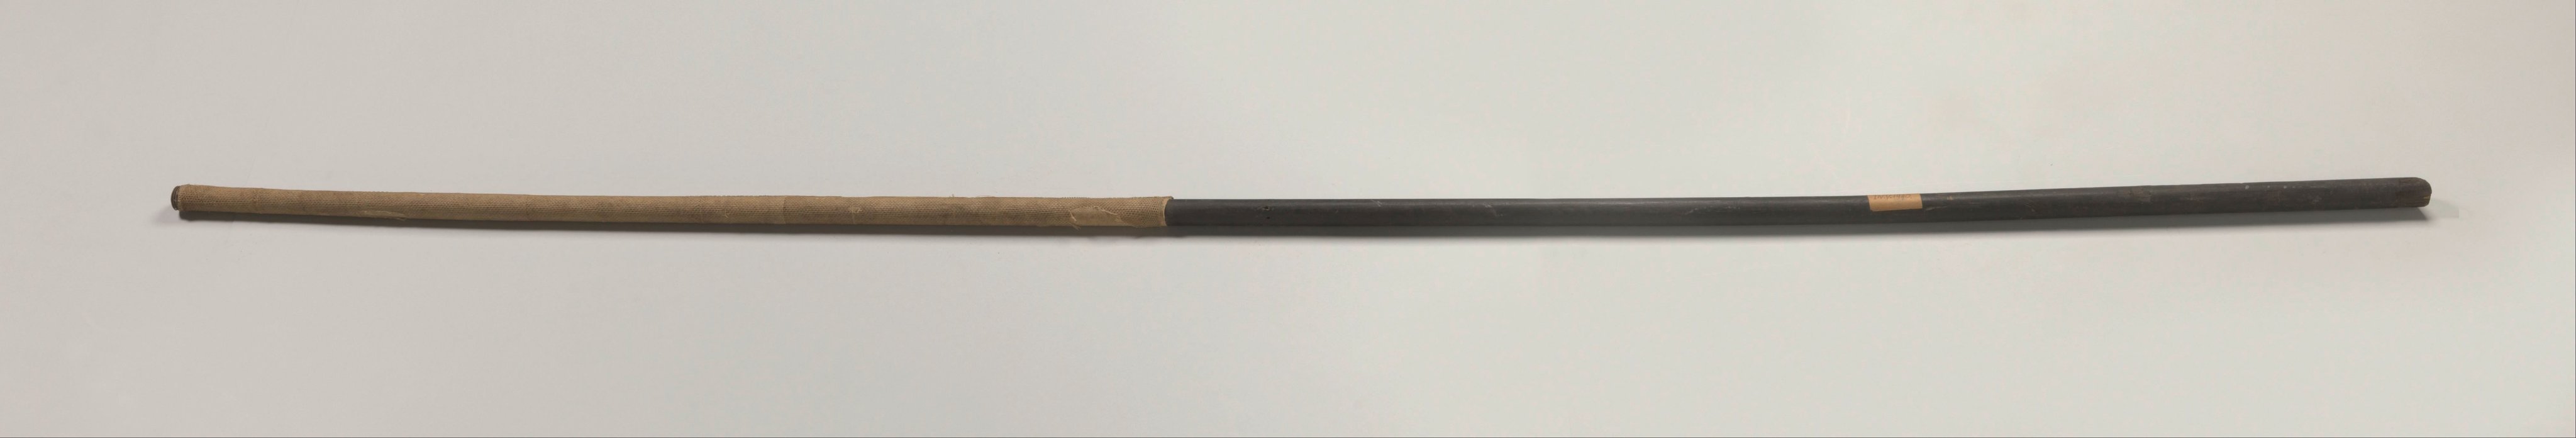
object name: stok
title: Stok van een vaandel van de gewapende burgermacht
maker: Anonymous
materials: linen, wood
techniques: lining, painted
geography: netherlands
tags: netherlands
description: Vaandel van het model van 13.2.1800. Ecru,op het midden een ovaal van twee naar beneden gebogen lauwertakken, die bovenaan bijeengehouden worden door een grote strik van rood- wit-blauw lint. De witte baan is breder dan de beide andere. Hierop staat in gouden klassieke kapitalen: 3DE BATAILLON, en: 3DE HALVE BRIGADE. In het ovaal een gaande leeuw in natuurlijke kleur met driekwart omgewende kop; in de opgeheven rechterpoot een kromzwaard met geel gevest. Hij loopt in een landschap onder een lichtbewolkte blauwe hemel. Paradekant: dito ovaal met lauwertakken, strik en opschrift. Op het rode ovaal in gouden klassieke kapitalen: VOOR HET VADERLAND EN DE WET.